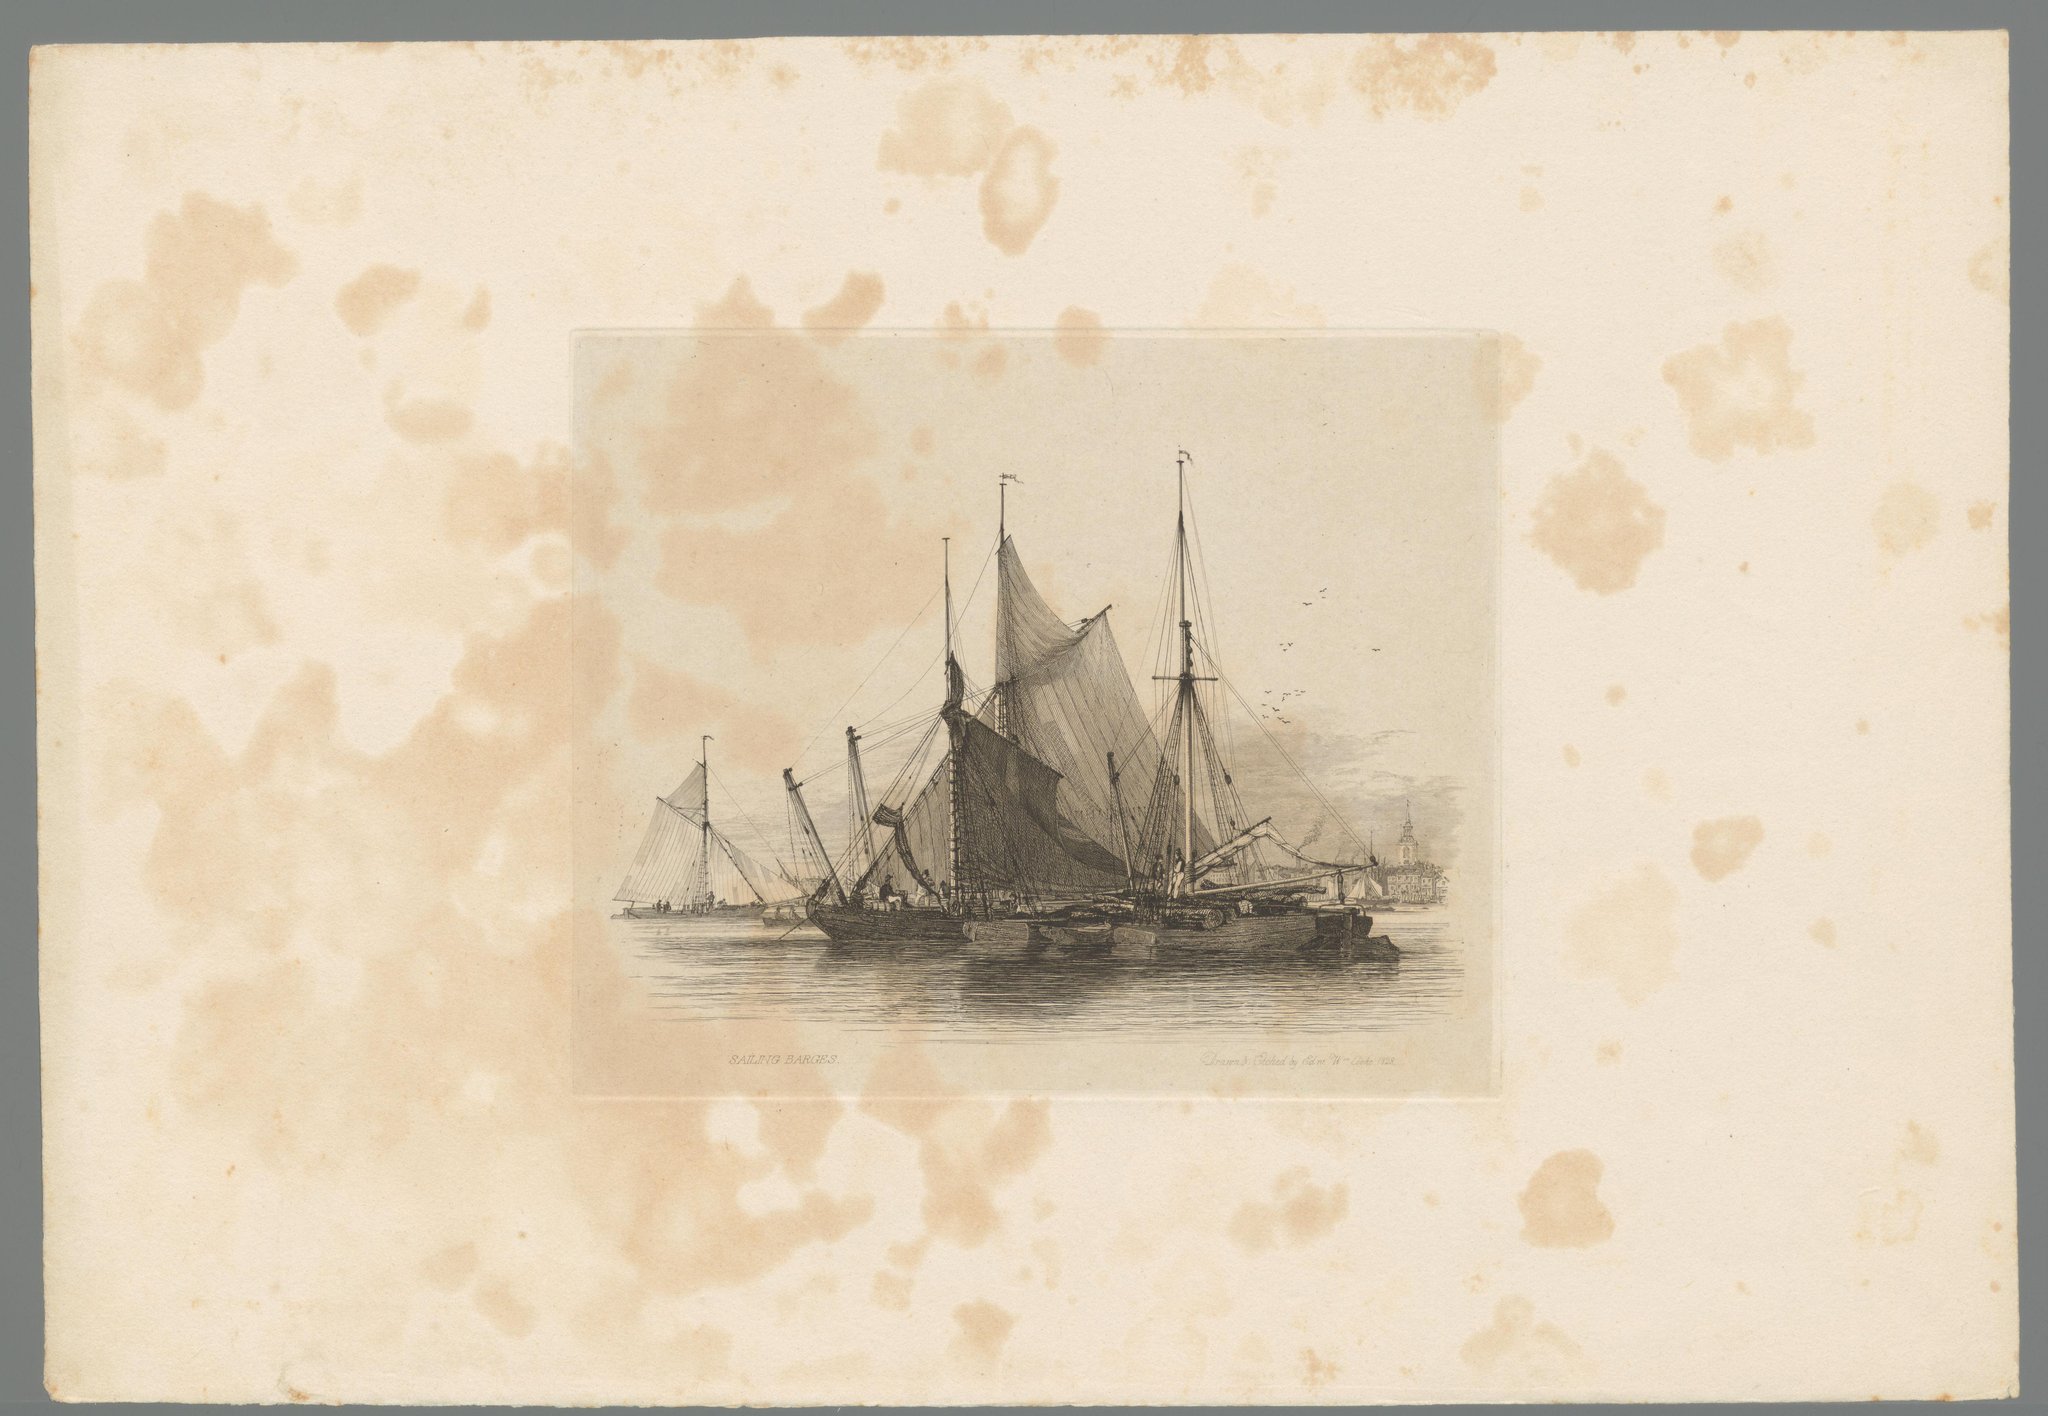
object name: print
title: Fifty Plates of Shipping and Craft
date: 1828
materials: paper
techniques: etching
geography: london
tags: city-view, and landscape with man-made constructions, sailing-ship, sailing-boat, river, london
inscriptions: collector's mark: Lugt 2165